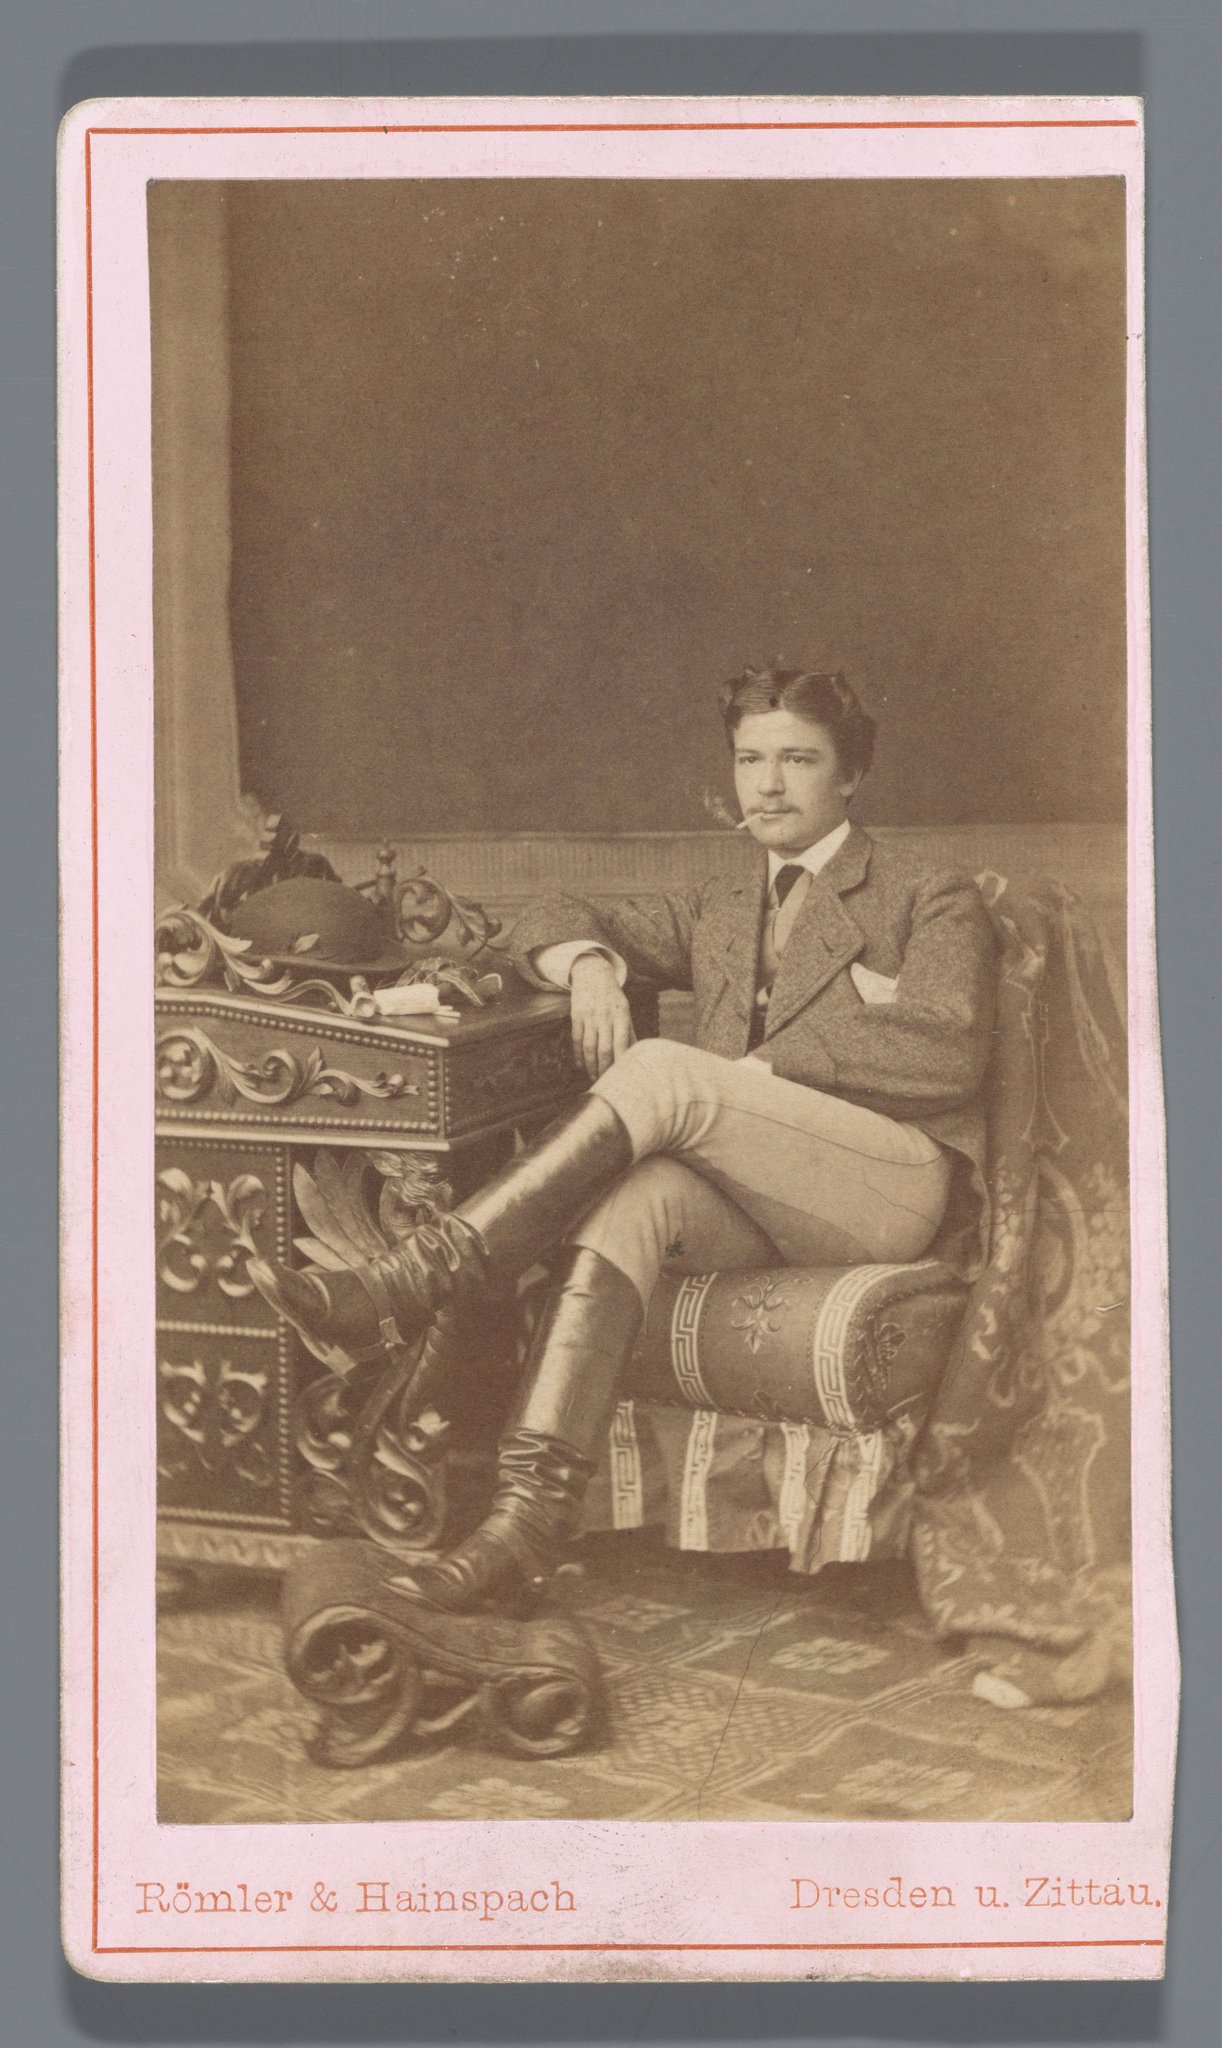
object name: photograph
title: Cartes-de-visite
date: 1870-1890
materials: cardboard, paper, photographic support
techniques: albumen print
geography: germany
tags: studio requisites ~ photographer, historical persons not known by name, germany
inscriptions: address: ‘Dresden Pragerstrasse No. 6 / Zittau Milchgasse am Stadtbade’, inscription: ‘Le temps passe, l'amour reste!’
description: Cartomanie was a collecting craze. From 1855 hundreds of thousands of these portraits were annually sold worldwide. People had photographs taken of their loved ones, including their pets, and kept them in an album. Portraits of kings, writers, artists, actors, and statesmen were also collected. Photography was no longer the preserve of the wealthy; farmers and maidservants now also stood before the camera.